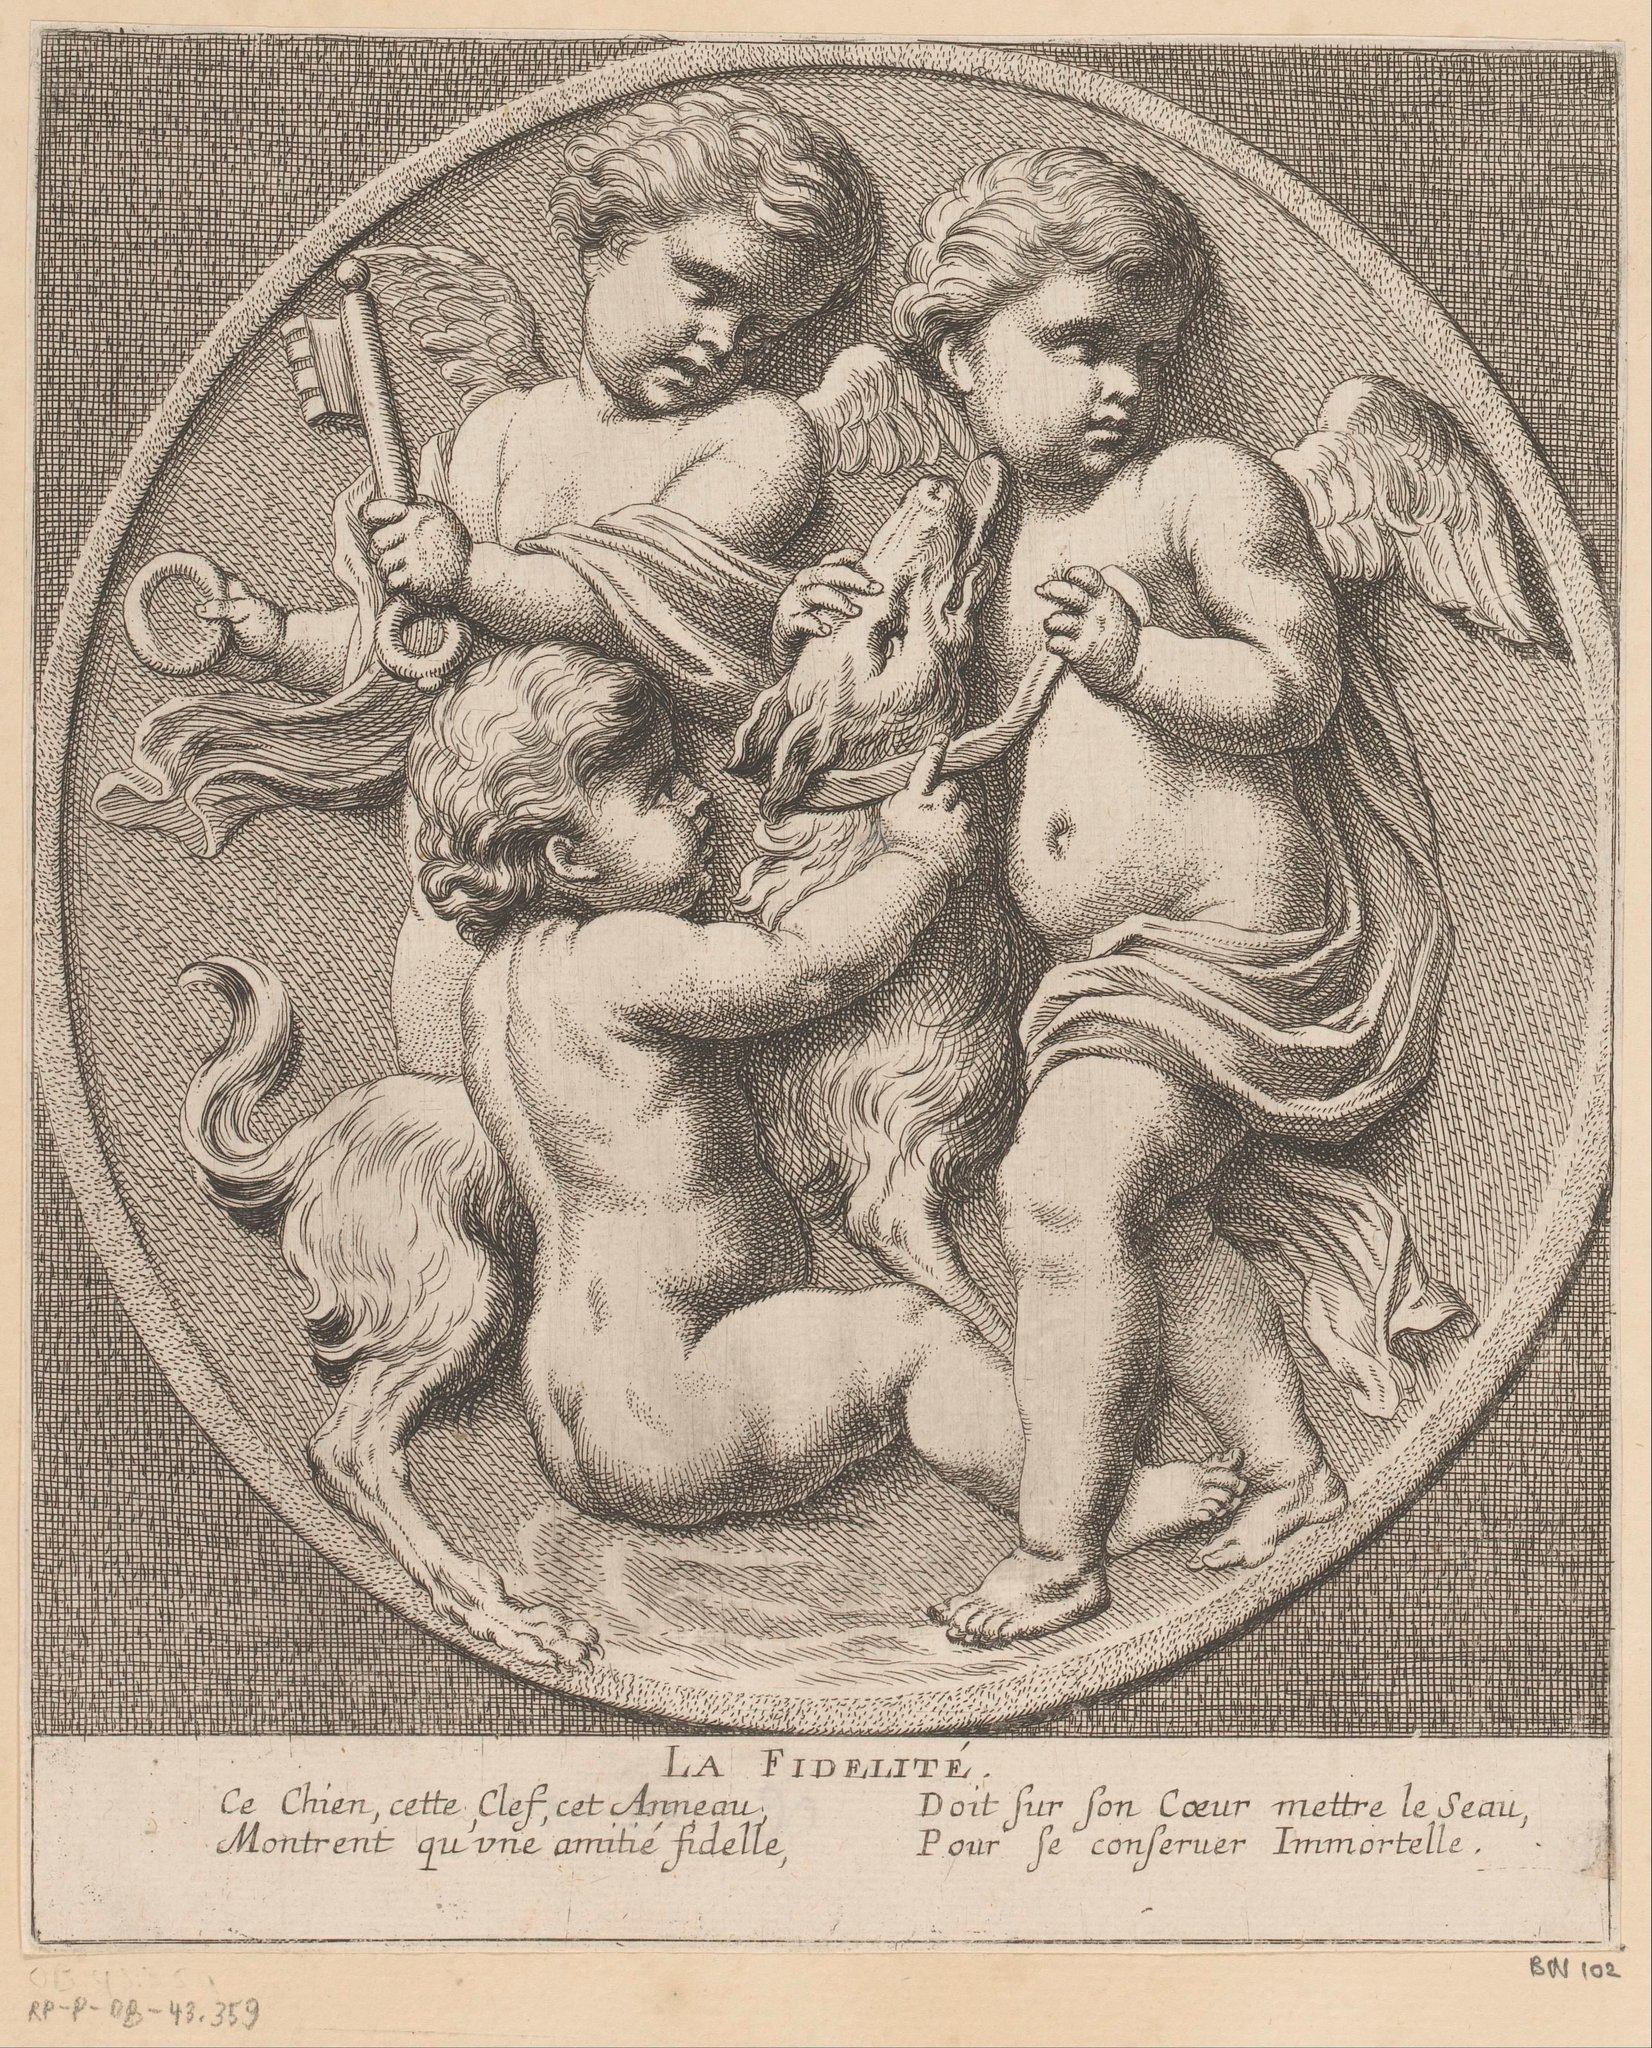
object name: print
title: Drie putti doen een hond een halsband om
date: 1654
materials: paper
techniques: etching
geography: france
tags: fidelity; 'fedeltà' (ripa), cupids: 'amores', 'amoretti', 'putti', collar (of a dog)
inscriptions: collector's mark: Lugt 240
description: Prent uit: Les vertus innocentes, ou leurs symboles sous des figures d'enfants. Parijs: Jacque van Merlen, 1654.